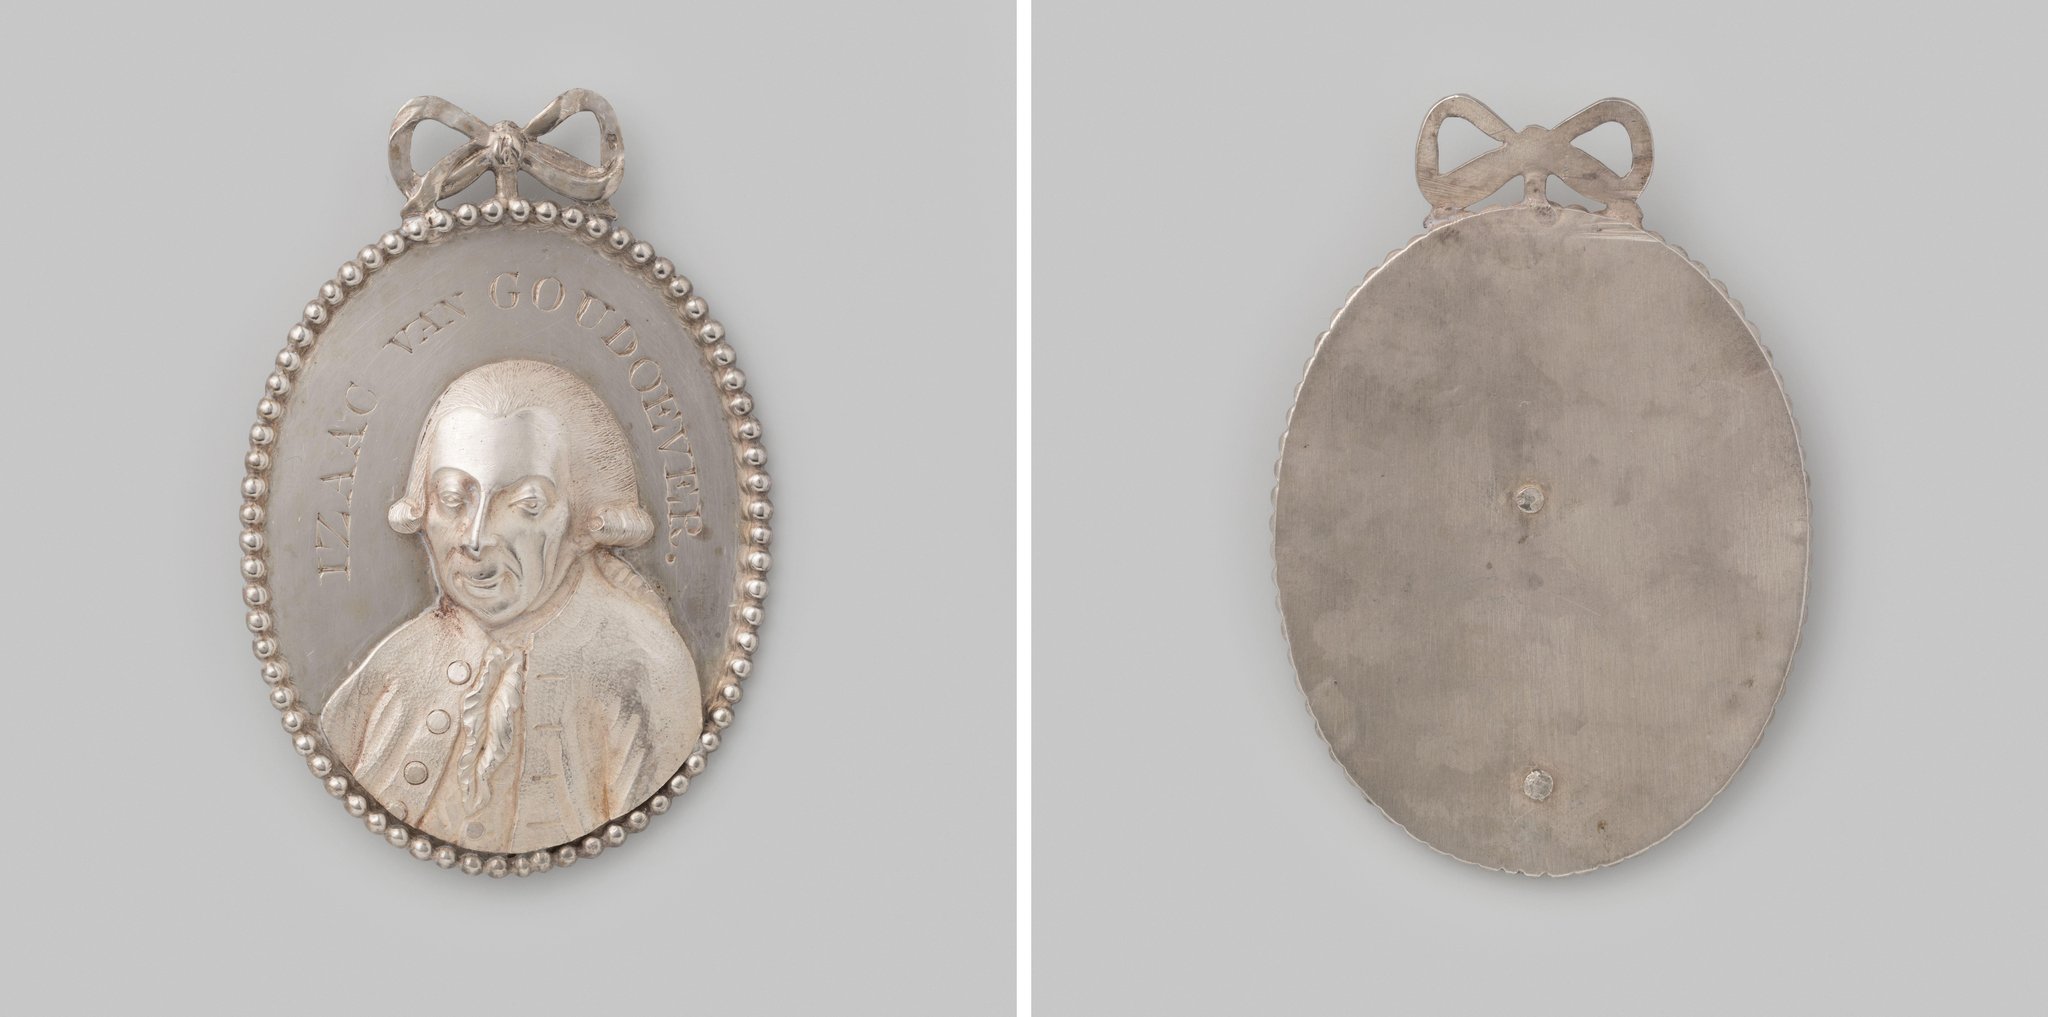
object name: insignia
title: Isaac van Goudoever, kolonel van het Witte regiment van de schutterij op de Dam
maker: Anonymous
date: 1787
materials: silver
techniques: casting, embroidery, fastening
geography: netherlands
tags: kolonel, isaak van goudoever, dam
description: Eenzijdig zilveren ovaal draagteken met parelrand en opengewerkte strik. Voorzijde: borststuk man binnen omschrift. Keerzijde: blanco; op keerzijde zijn nog twee nagels zichtbaar, waarmee voor- en keerzijde aan elkaar zijn bevestigd